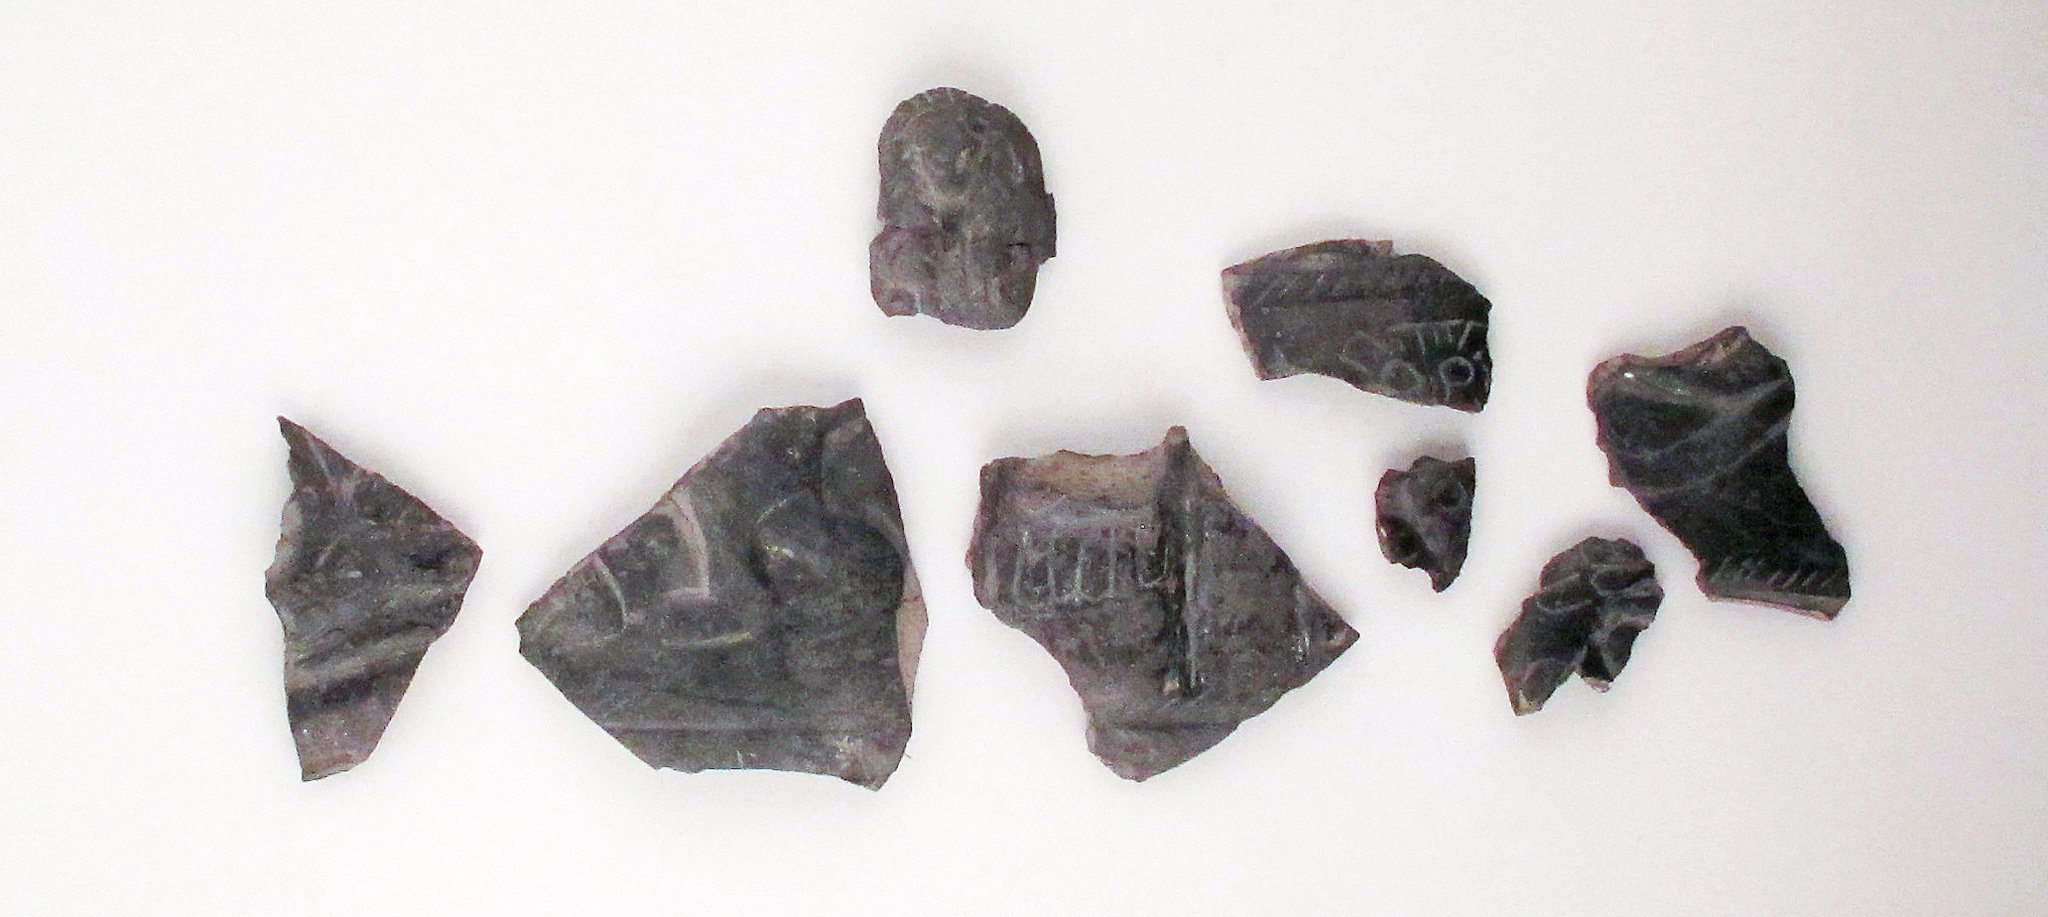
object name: vase fragment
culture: etruscan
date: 575-550 BCE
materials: terracotta